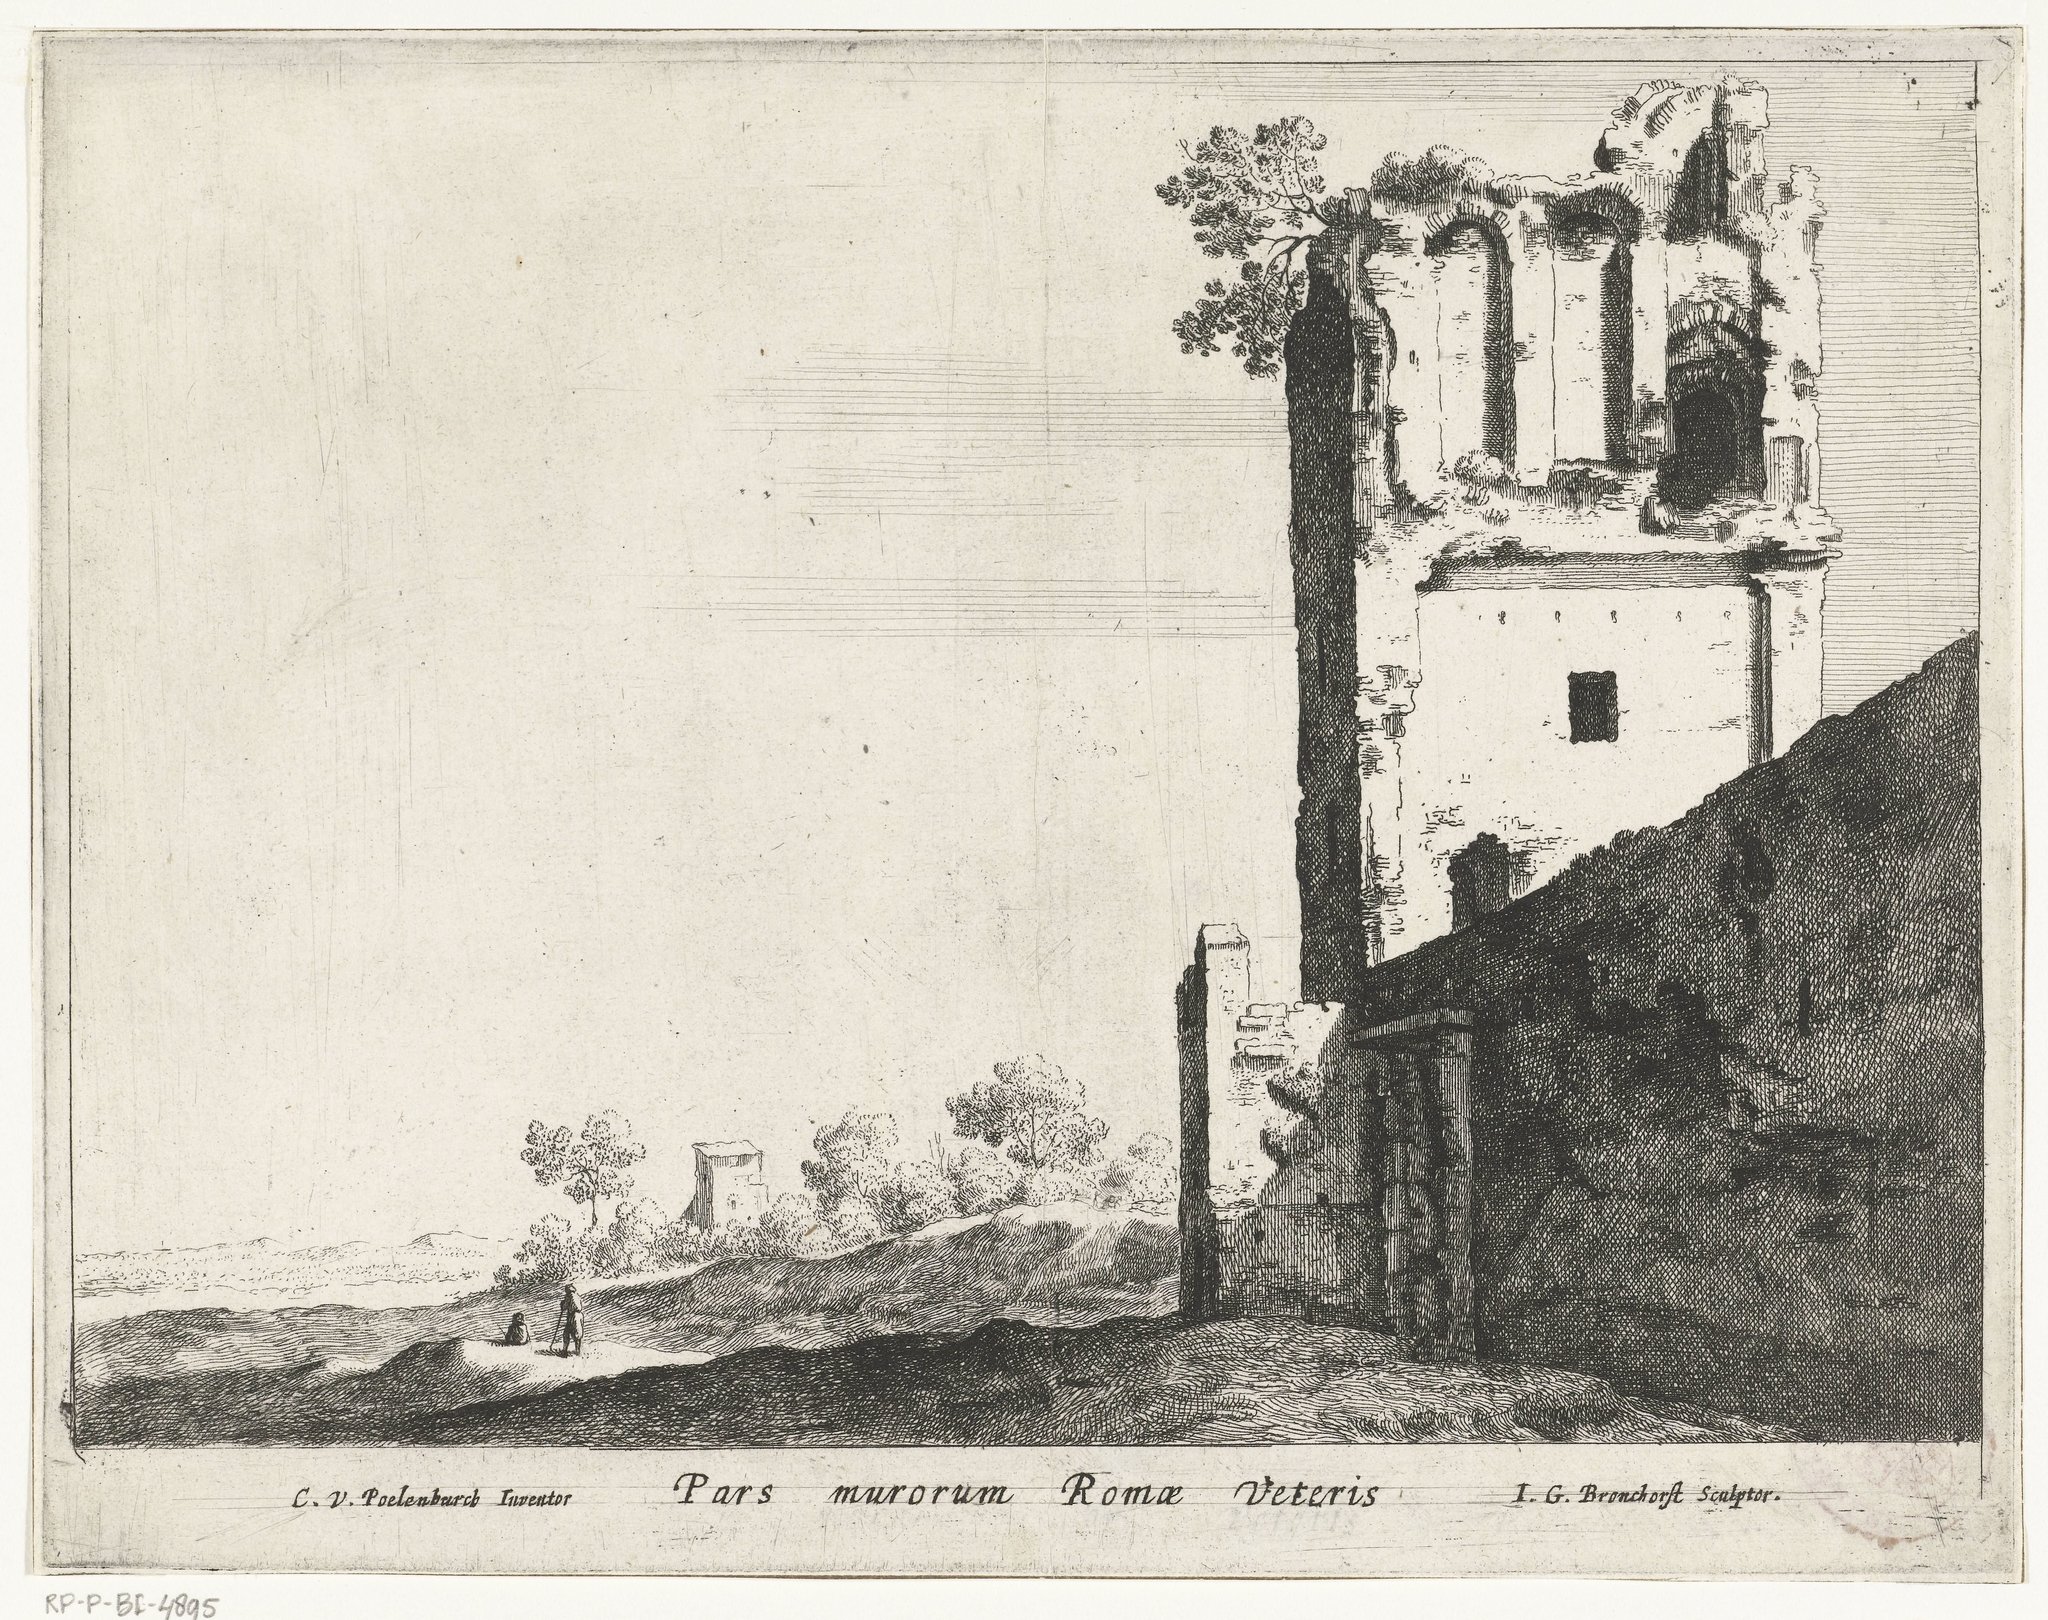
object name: print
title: Ruïnes in Rome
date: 1613-1661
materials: paper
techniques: etching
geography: netherlands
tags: ruin of a building ~ architecture, landscape with ruins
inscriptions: collector's mark: Lugt 240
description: Prent naar ontwerp van Cornelis van Poelenburch. Prent uit serie van negen prenten met Romeinse ruïnes.